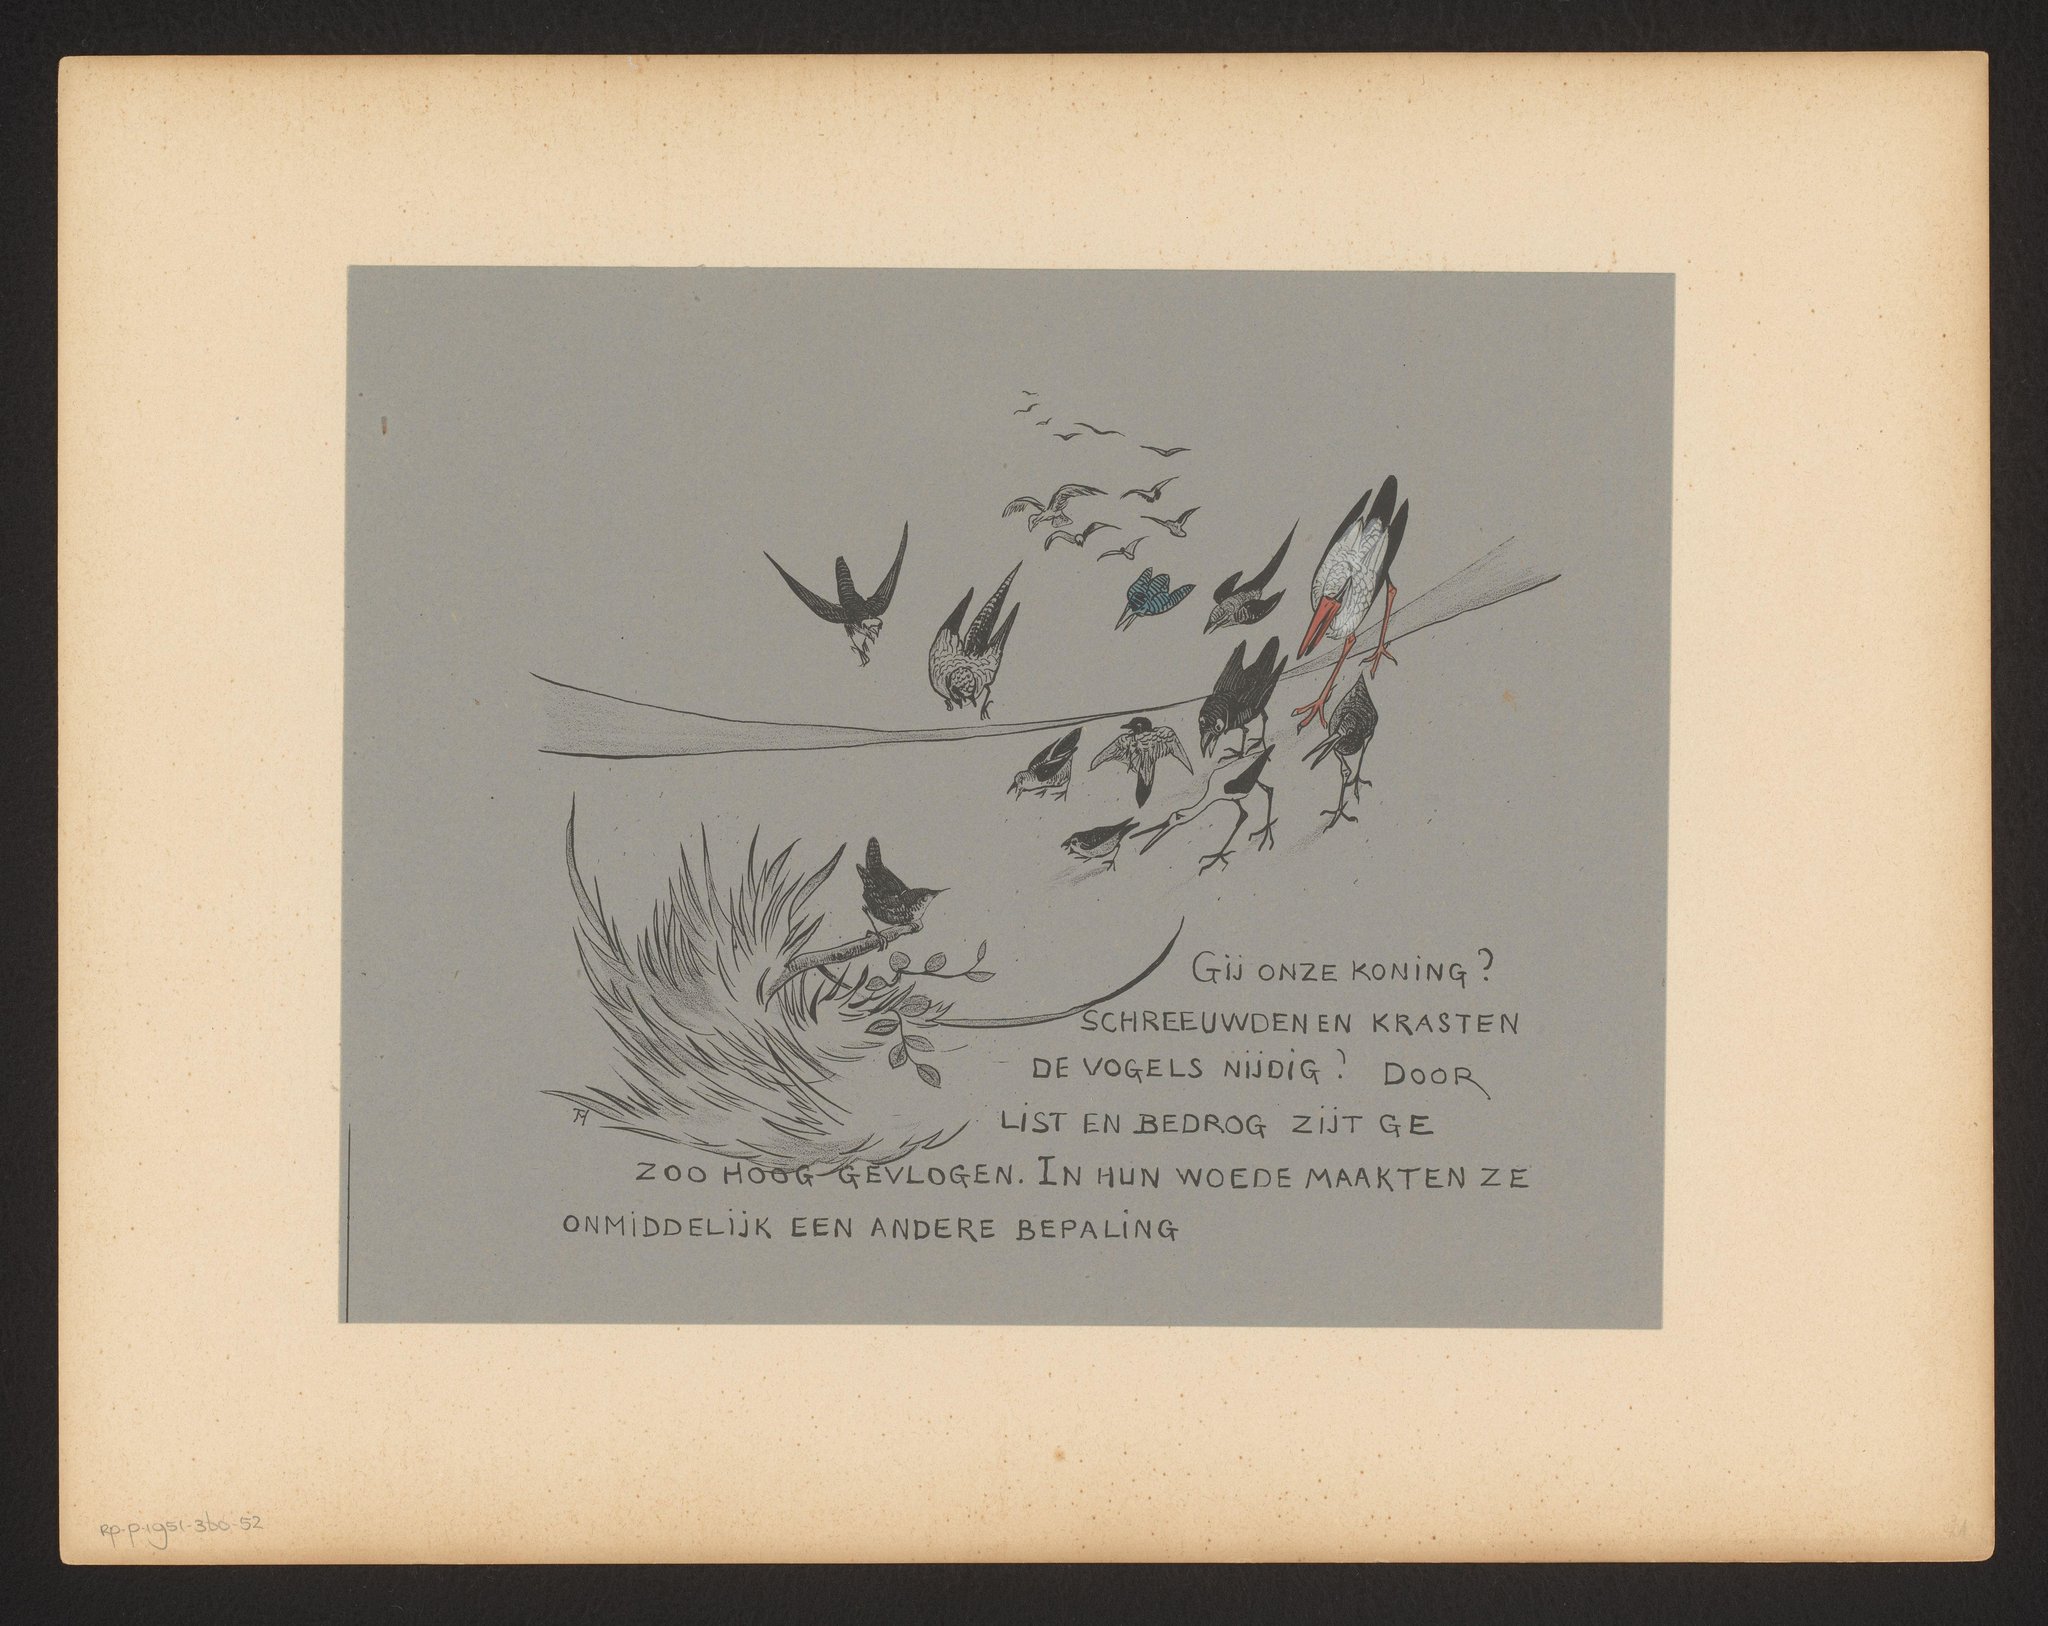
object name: print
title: Hoe de vogels aan een koning kwamen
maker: theo van hoytema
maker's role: draughtsman, painter, print maker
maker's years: 1863-1917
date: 1892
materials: paper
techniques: hand coloring, lithograph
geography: the hague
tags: song-birds: wren, groups of birds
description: Zowel tekst als afbeelding zijn gelithografeerd.